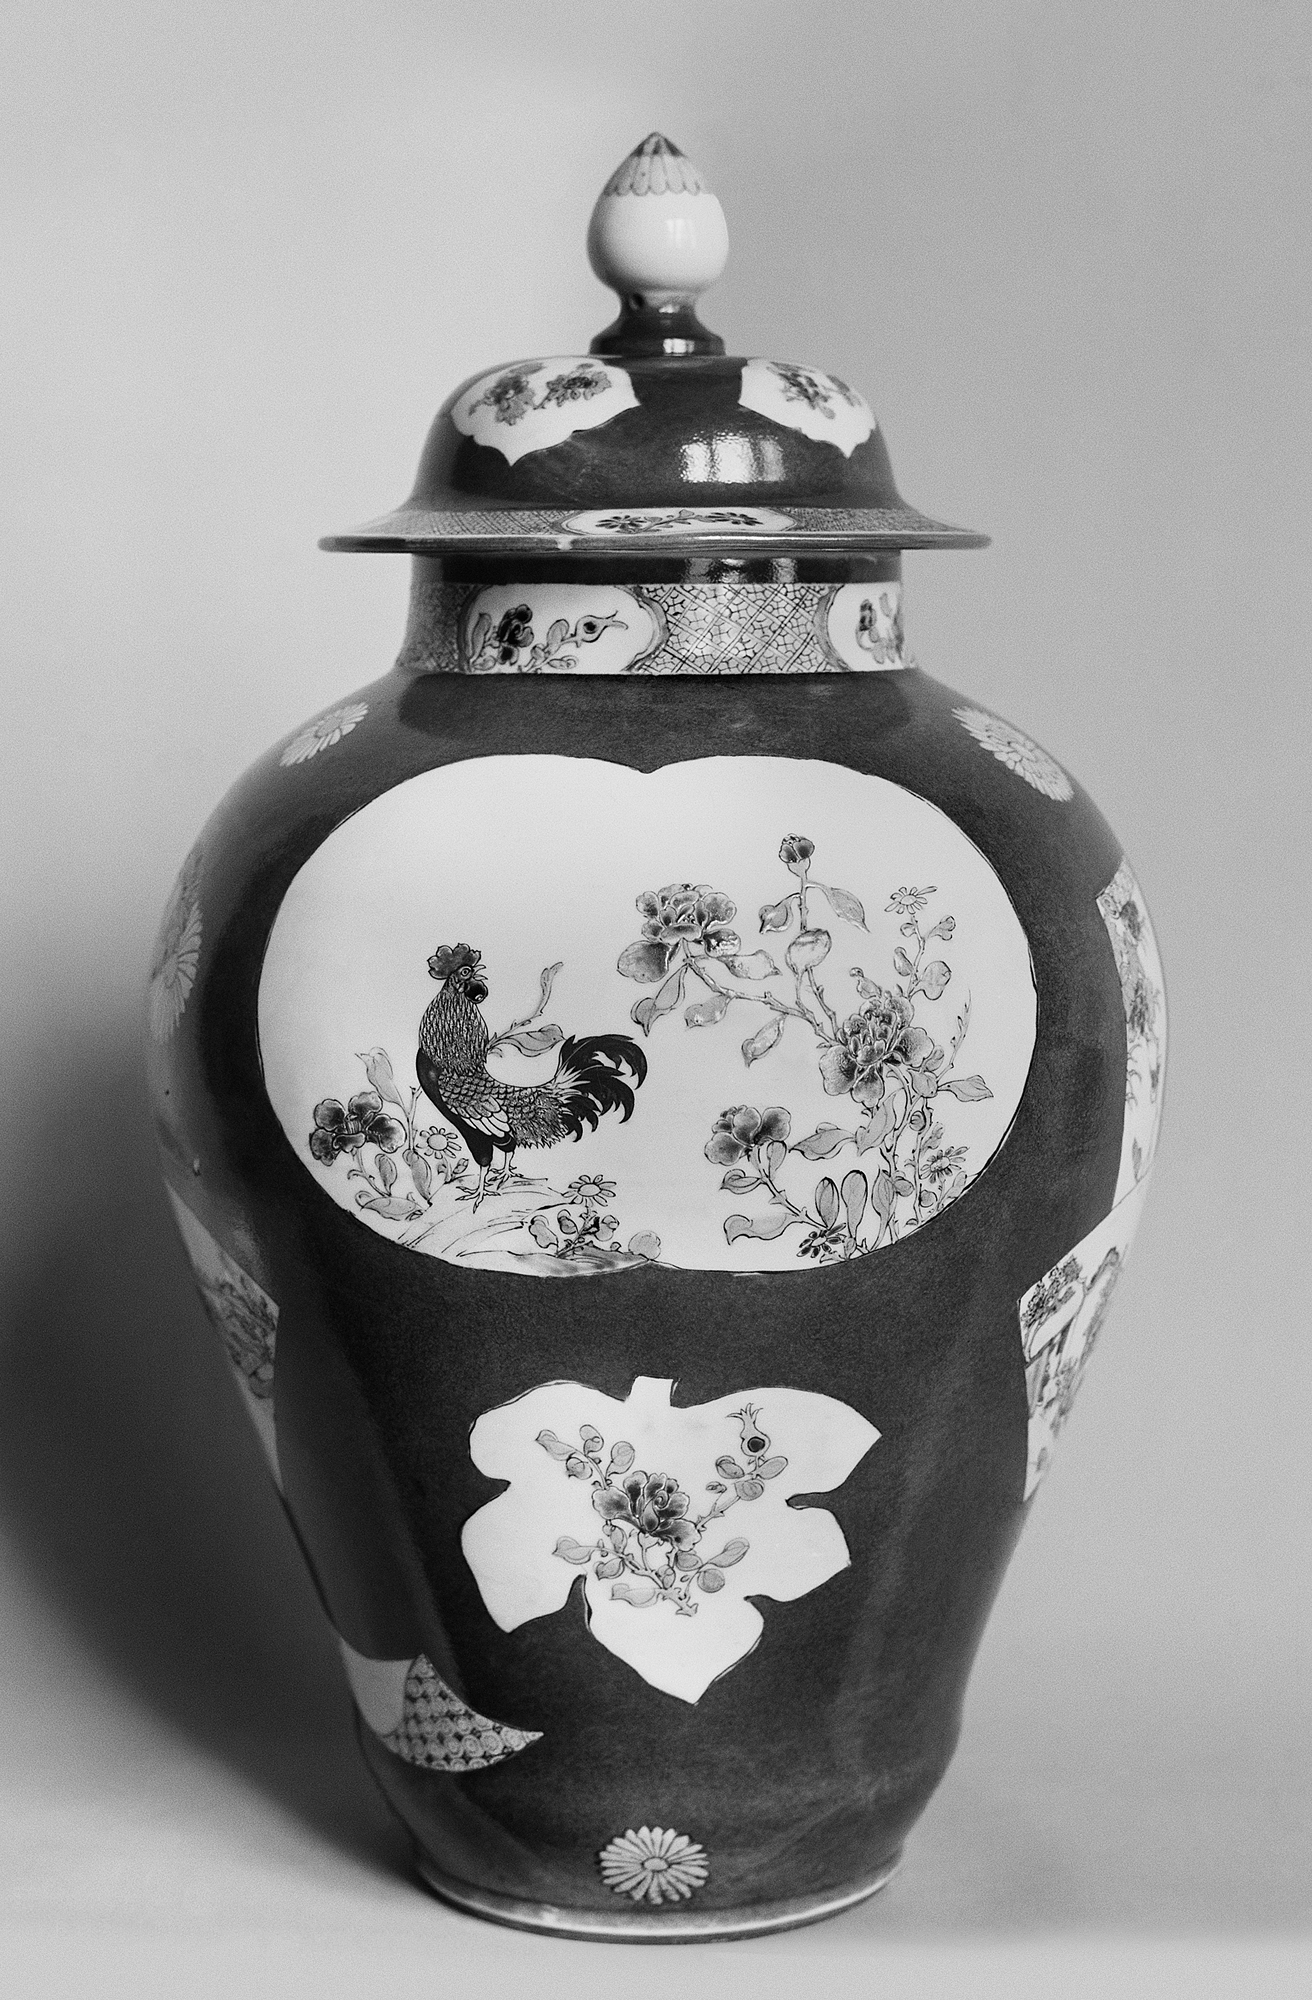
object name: jar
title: Jar with Rooster and Flowers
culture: chinese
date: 1734-1766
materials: enamel, porcelain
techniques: overglaze, painting, polychrome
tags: roosters